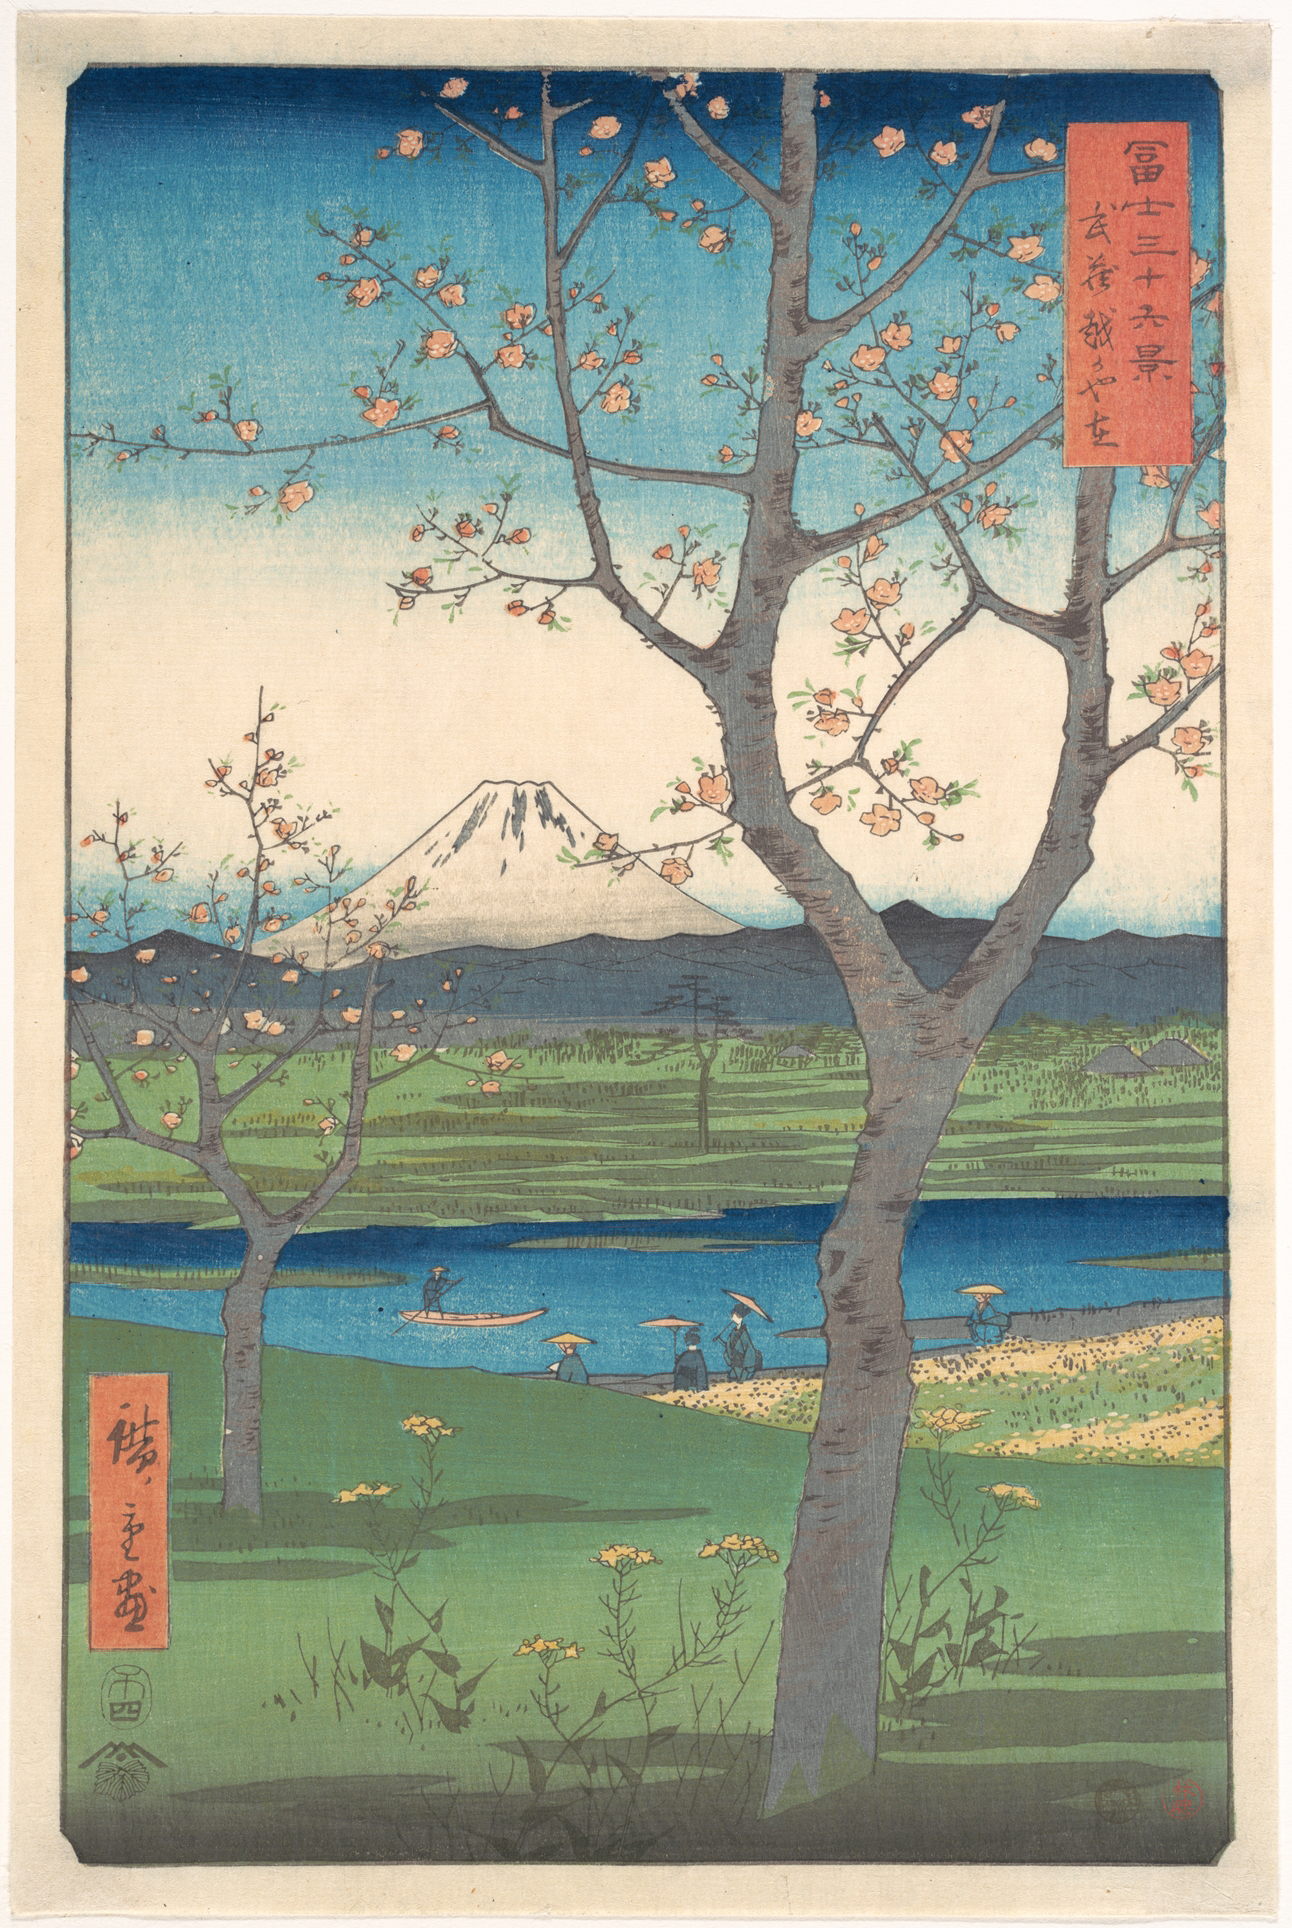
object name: print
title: Musashi, Koshigaya Zai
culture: japanese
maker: utagawa hiroshige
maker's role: artist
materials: ink, paper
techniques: woodblock print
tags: human figures,mountains,landscapes,trees,boats